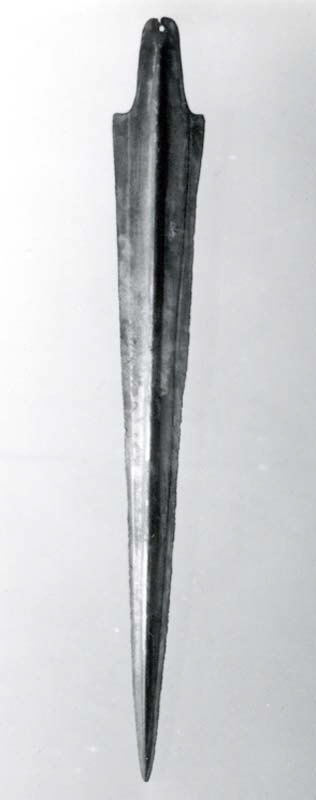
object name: sword or dagger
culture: hattian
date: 2300-2000 BCE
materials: bronze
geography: central anatolia